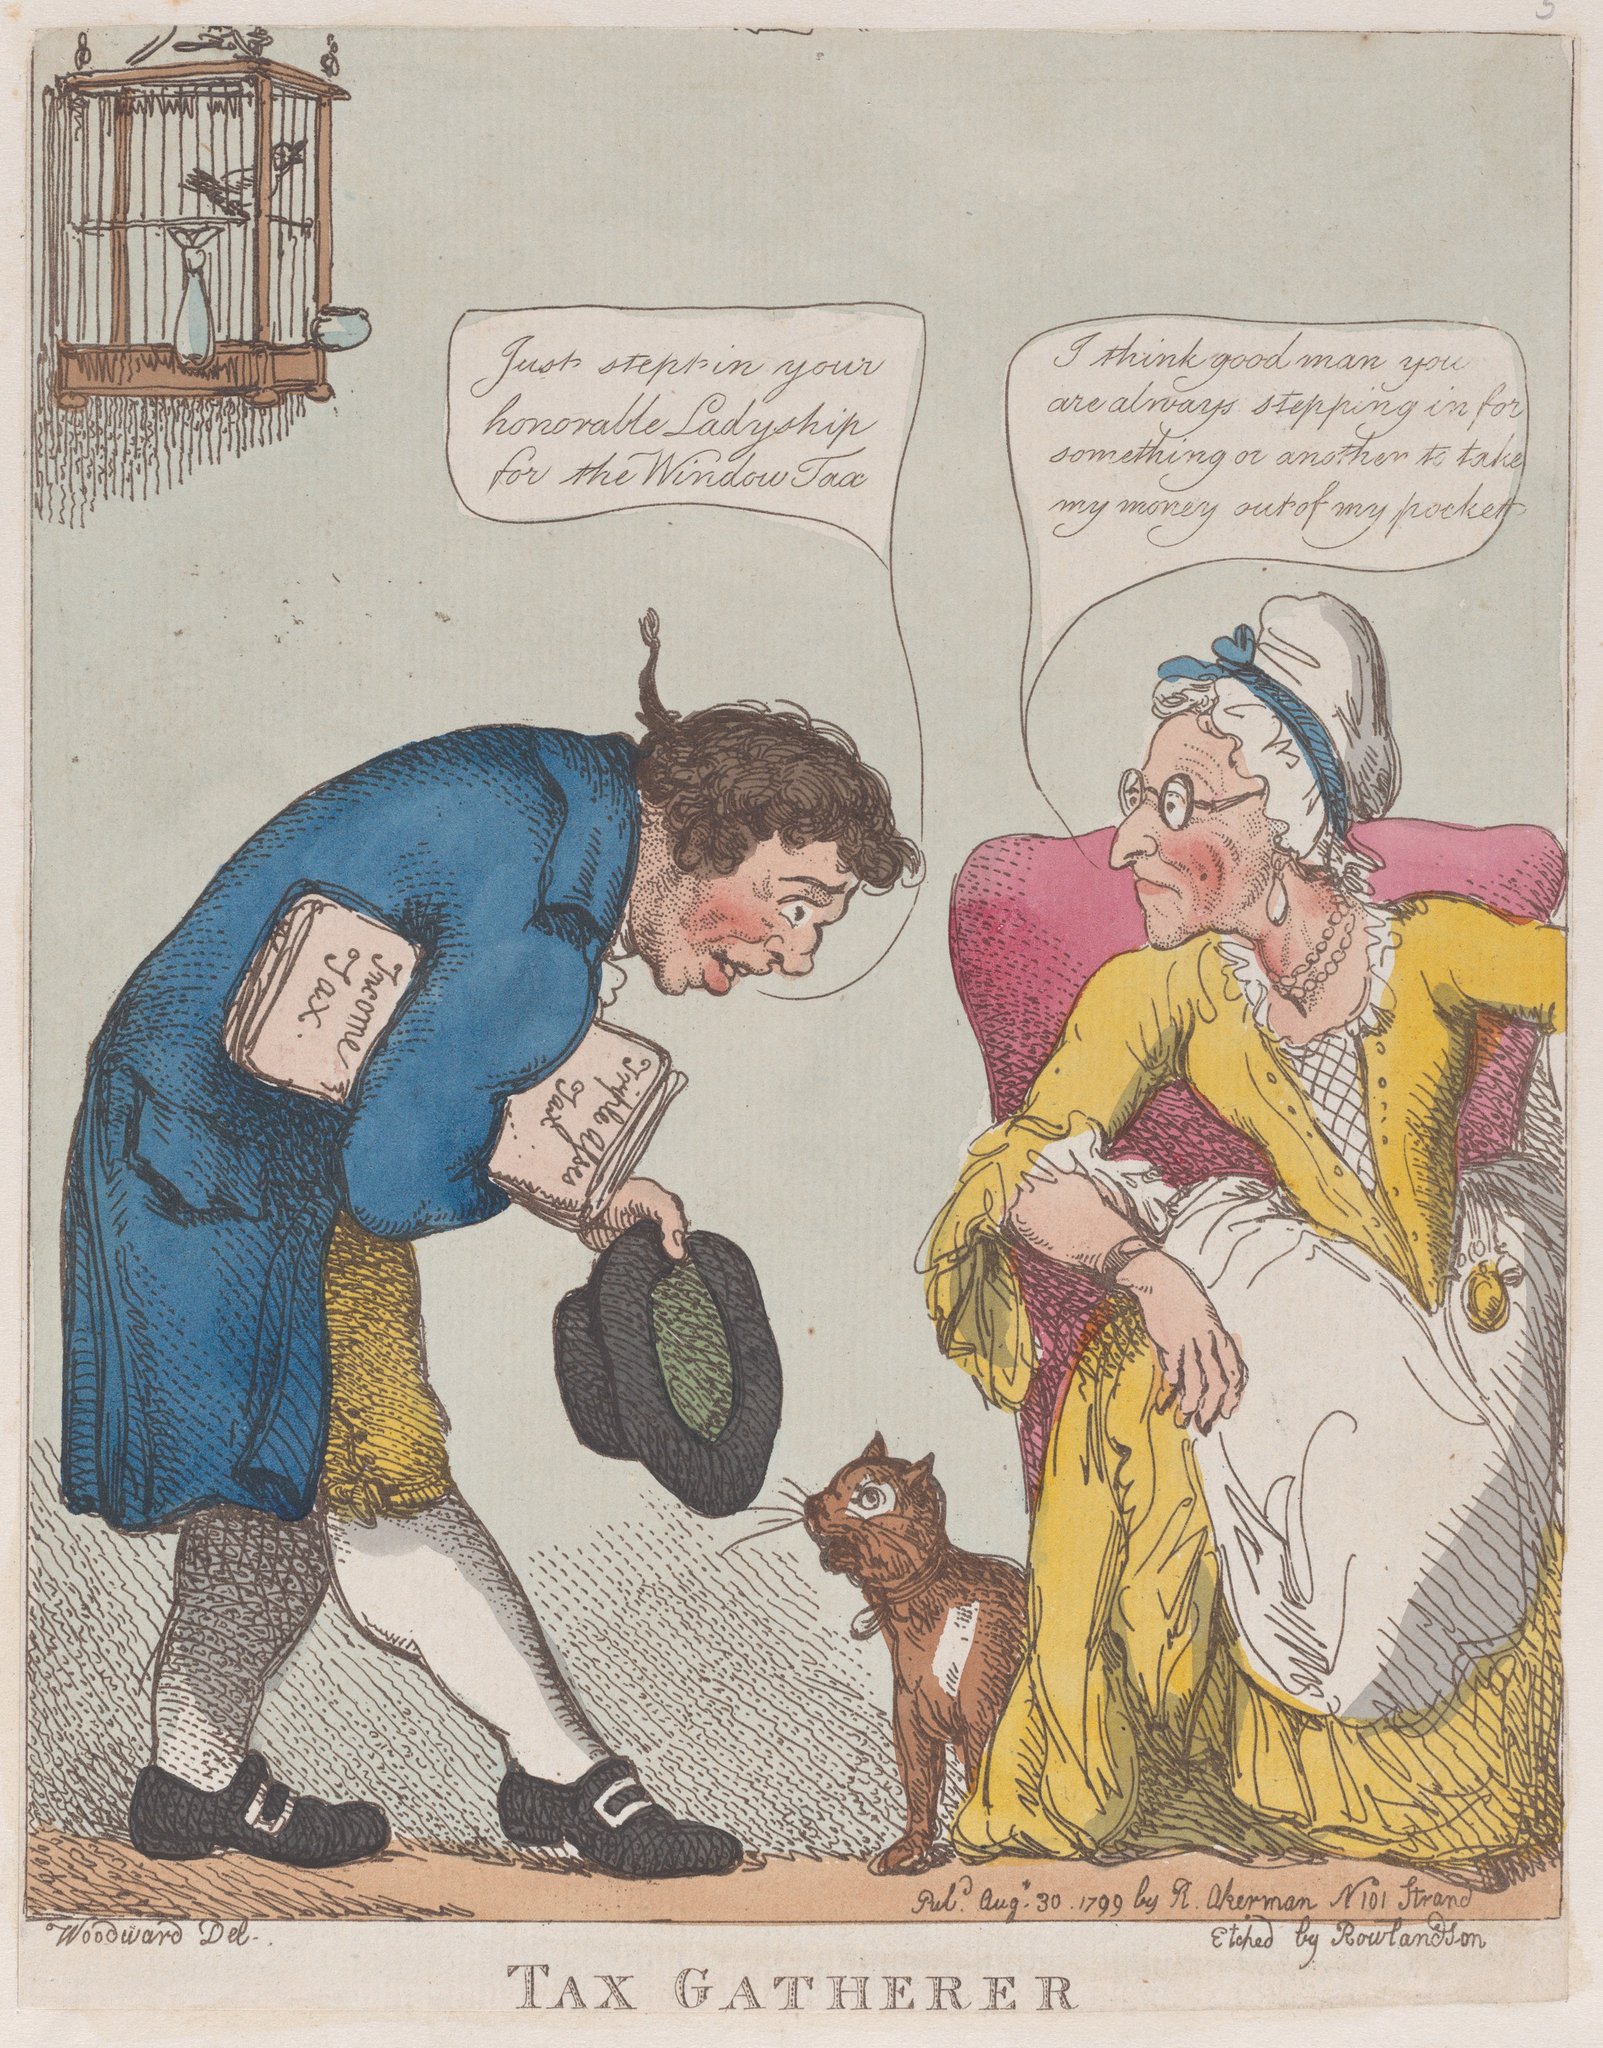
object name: print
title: Tax Gatherer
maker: thomas rowlandson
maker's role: artist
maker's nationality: british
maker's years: 1757-1827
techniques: etching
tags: satire,men,women,cats